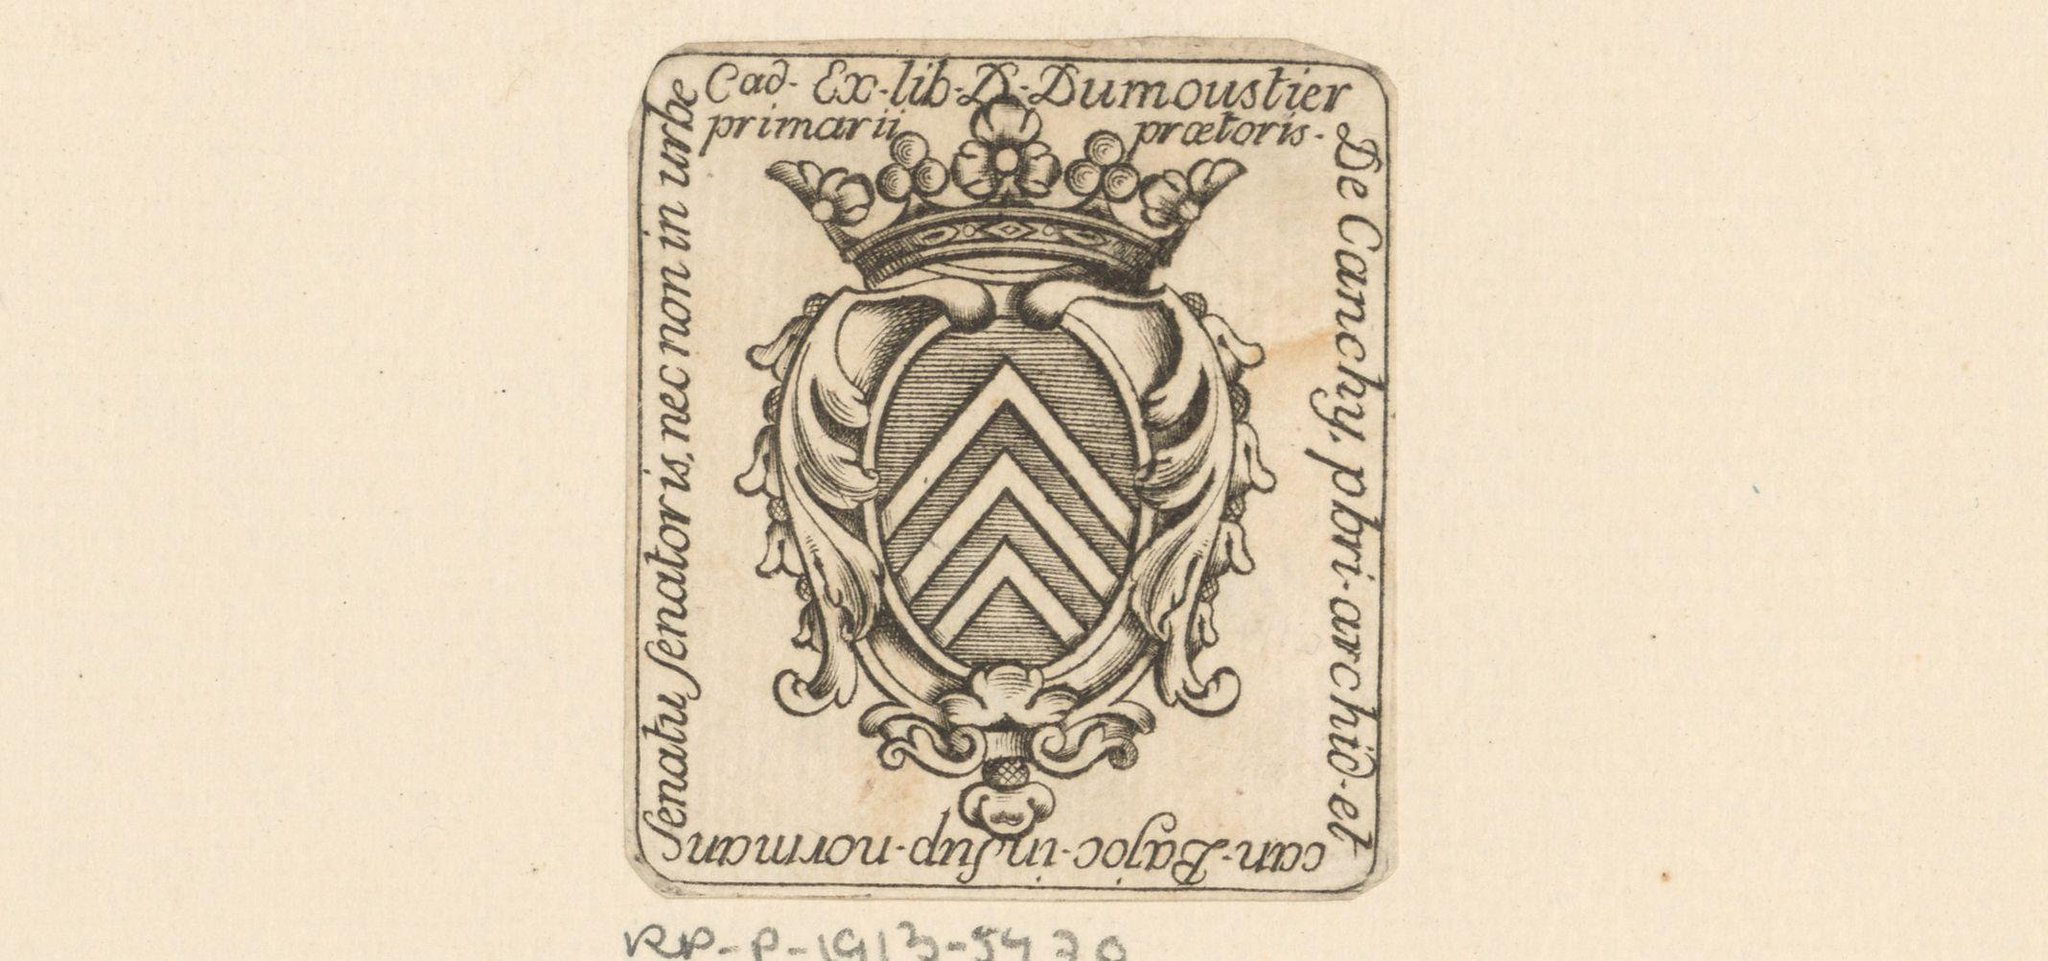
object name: bookplate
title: Cad. ex lib. D. Dumoustier De Cranchy pbri. archid. (...)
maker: Anonymous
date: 1600-1749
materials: paper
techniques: engraving, etching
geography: france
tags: armorial bearing, heraldry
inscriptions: collector's mark: Lugt 2233, collector's mark: Lugt 2760